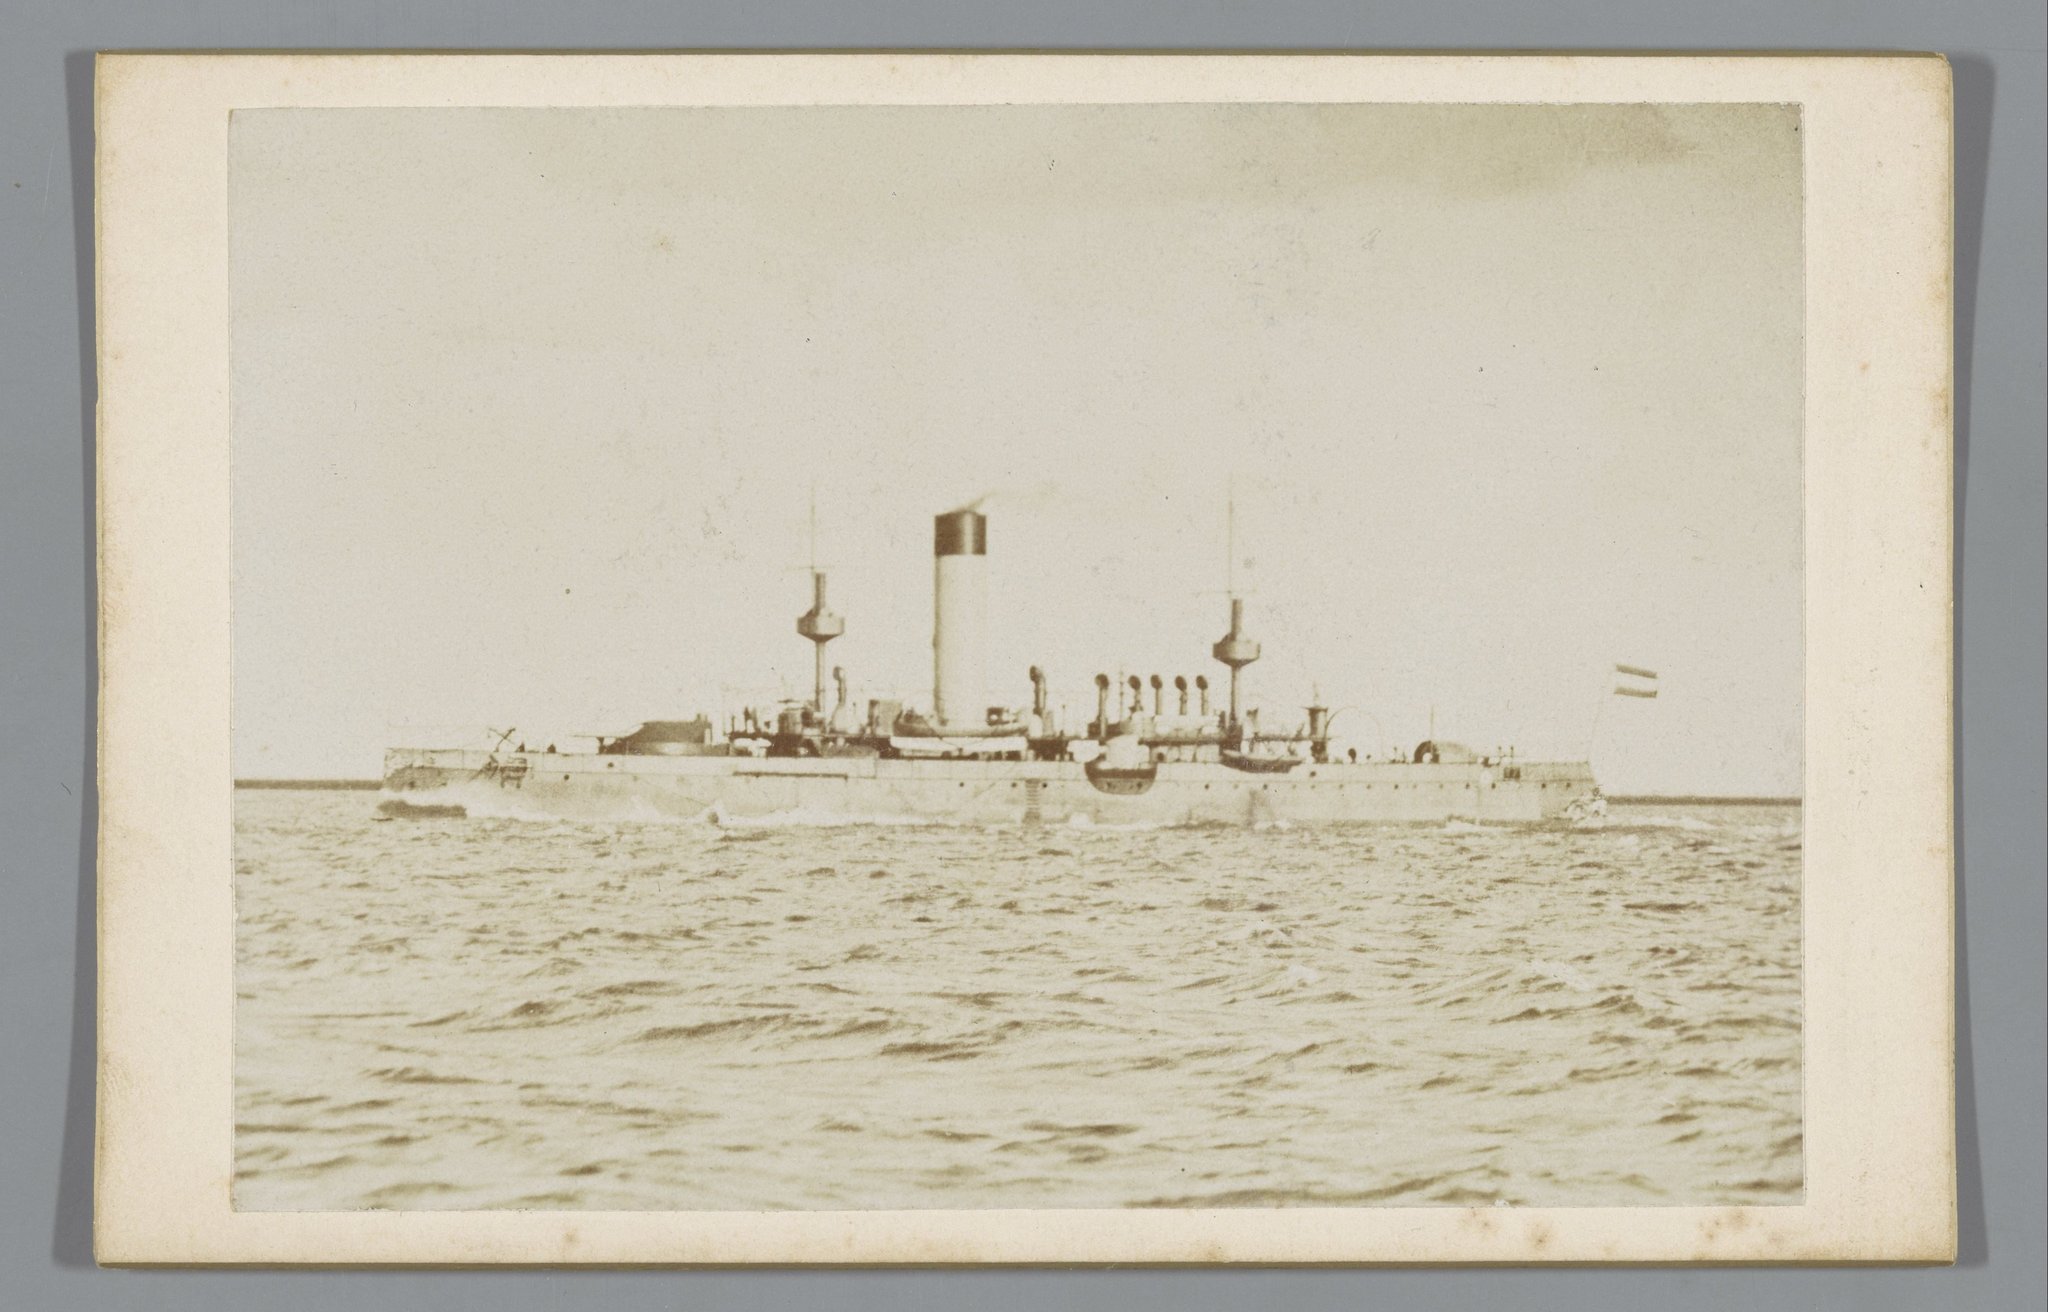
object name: cabinet photograph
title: Pantserschip Hr. Ms. Evertsen op zee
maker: Anonymous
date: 1896-1910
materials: paper, cardboard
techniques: collodion silver print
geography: netherlands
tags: navy, steamship, motorship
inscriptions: inscription: ‘Type A/ Evertsen/ Piet Hein/ Cortenaer’, collector's mark: ‘Vosmaer’